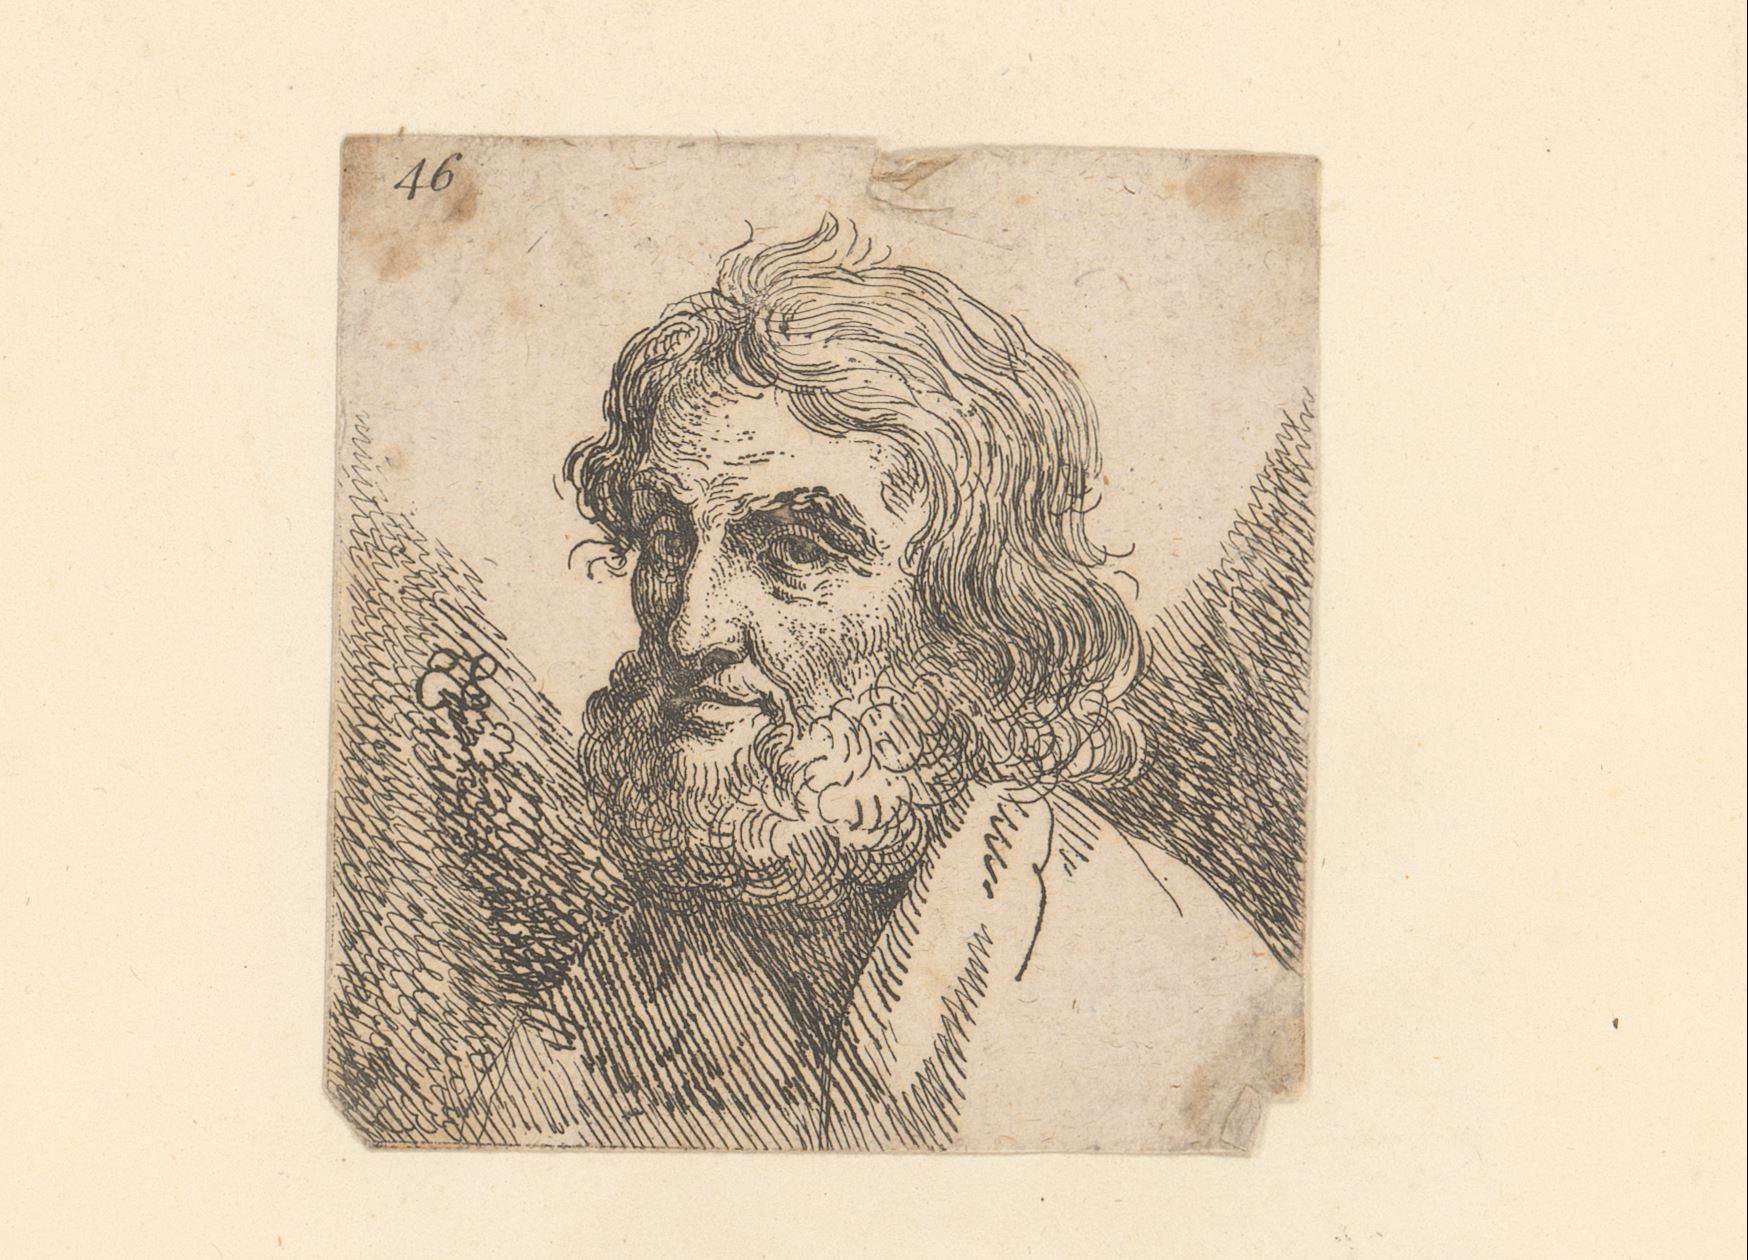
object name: print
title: Etsen door E. Edwards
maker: edward edwards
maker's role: painter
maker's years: 1738-1806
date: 1748-1806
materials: paper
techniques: etching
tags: head (human), adult man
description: Prent maakt deel uit van een serie van 51 prenten, bestaande uit twee delen met landschappen (36 prenten) en figuren en portretten (15 prenten), voor het eerst uitgegeven in Londen in 1790.